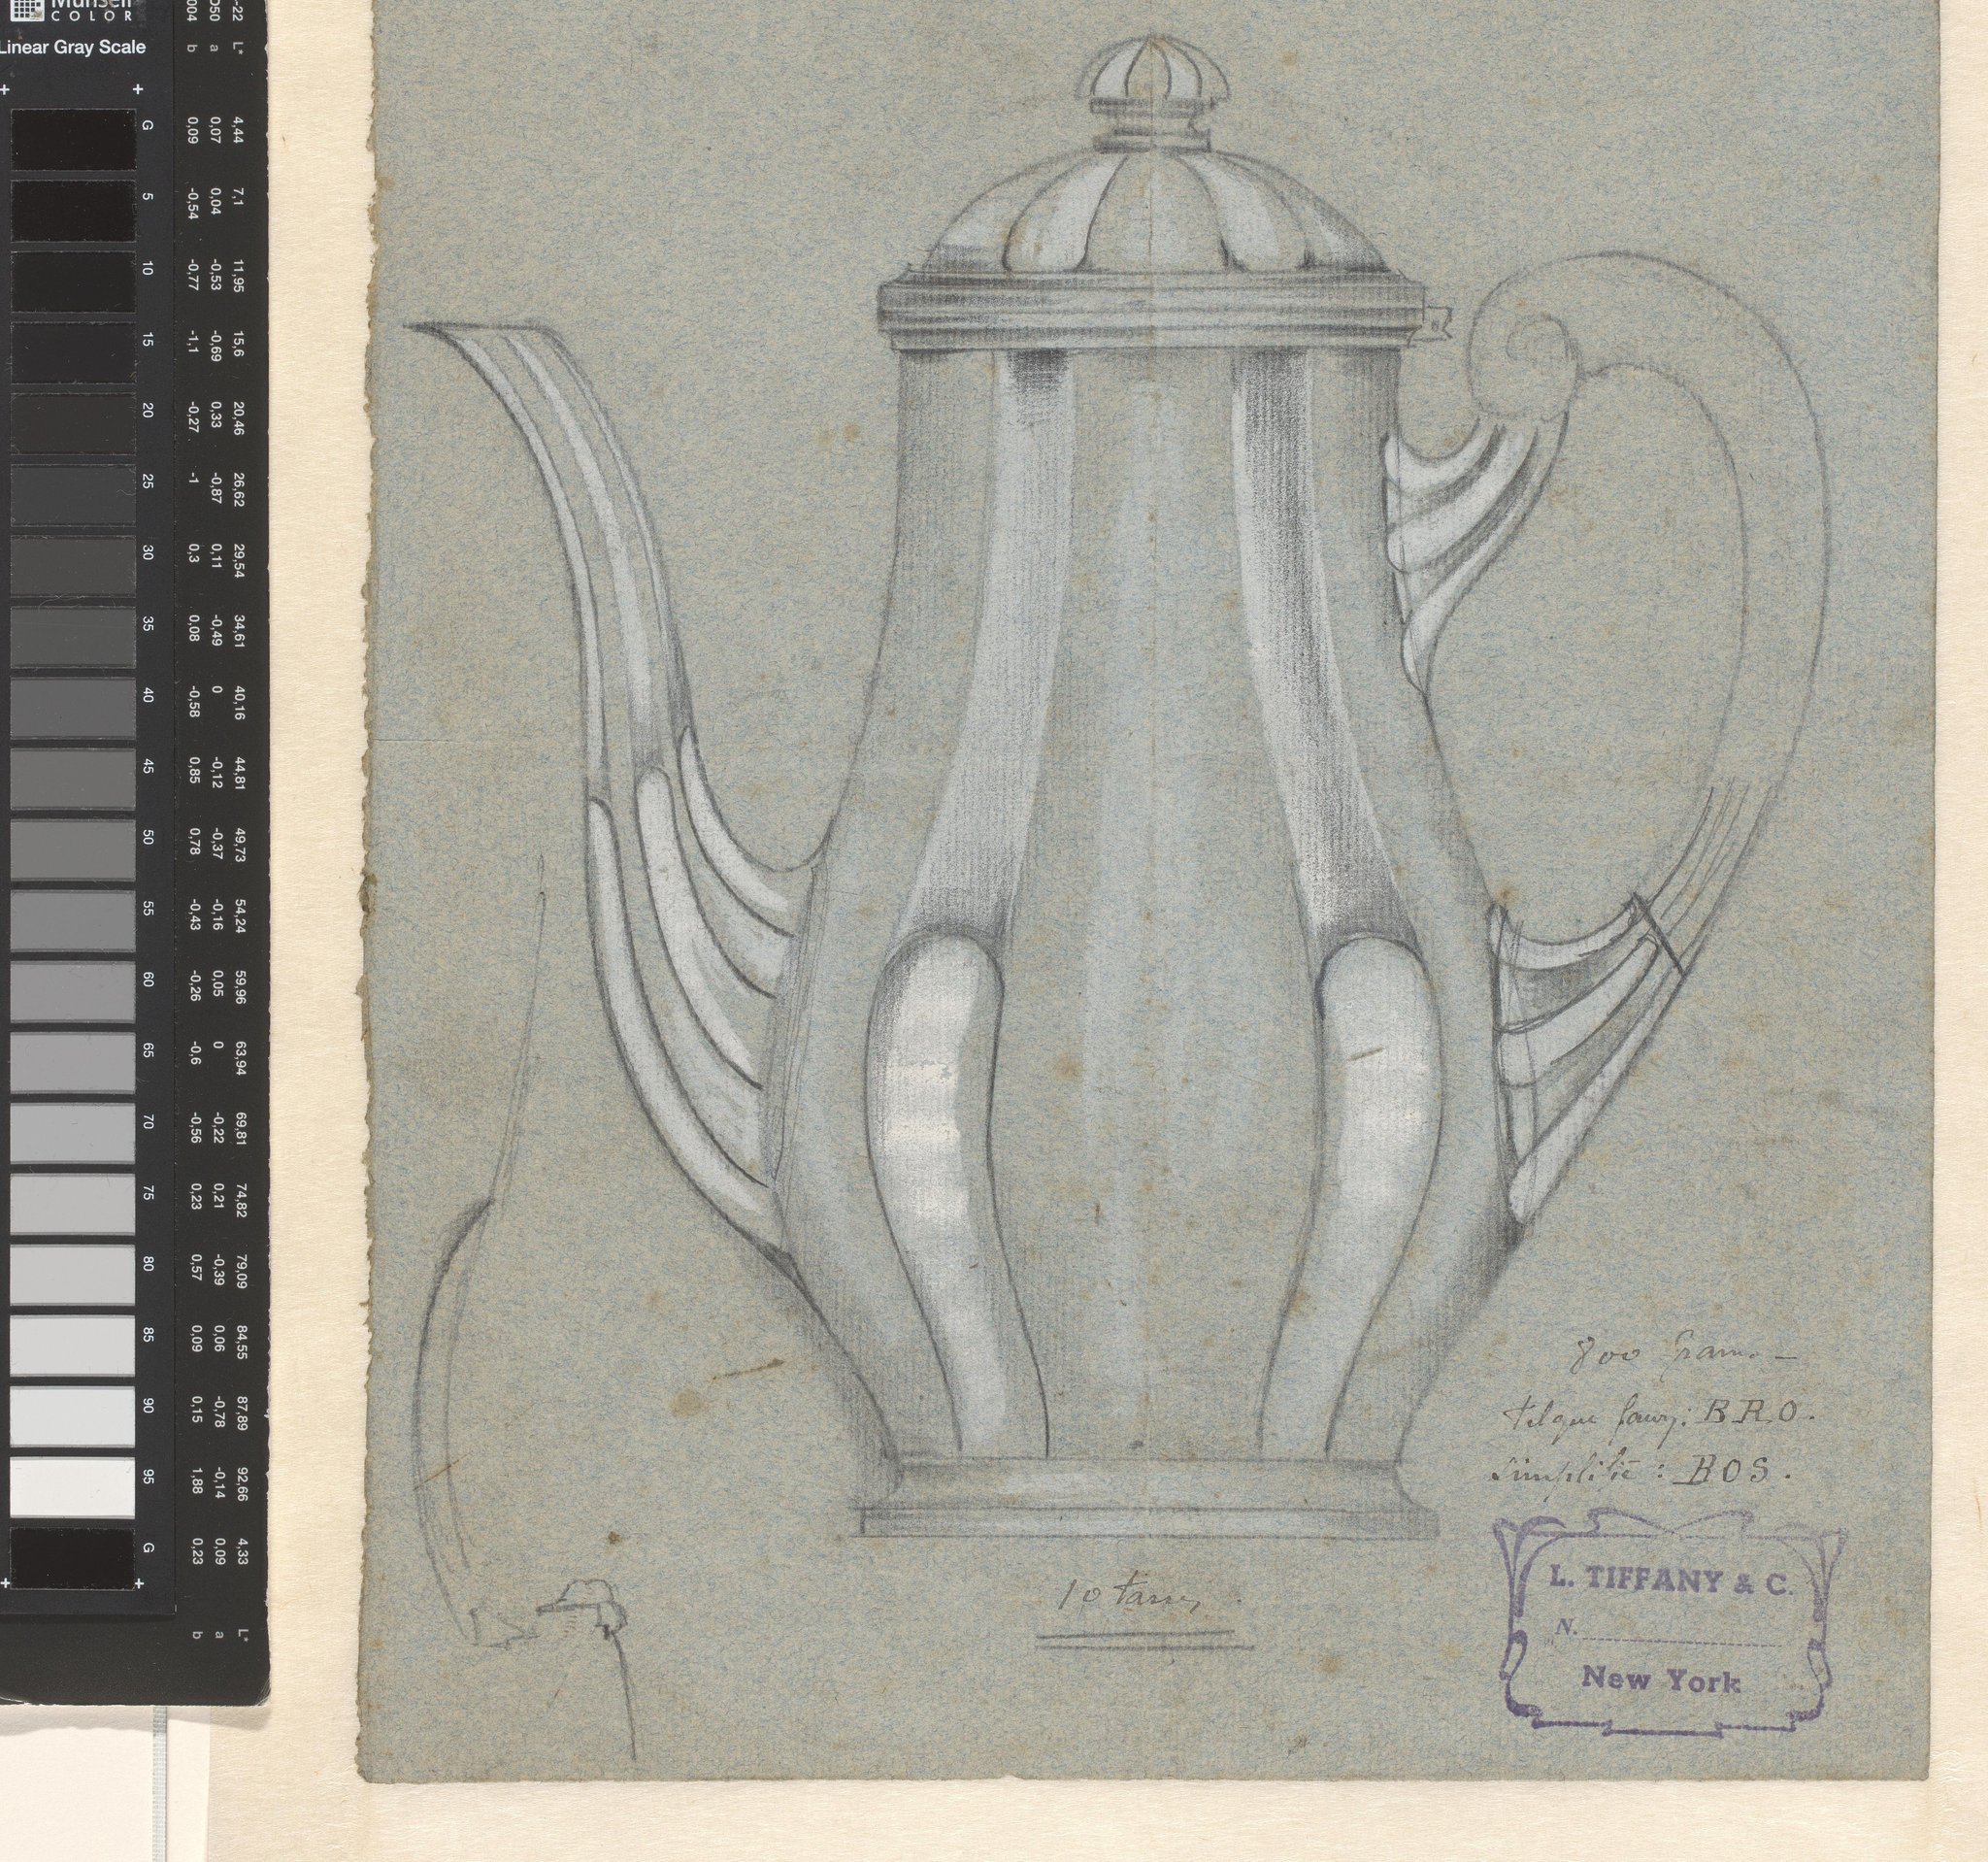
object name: design drawing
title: Ontwerp voor een koffiepot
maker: louis comfort tiffany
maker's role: designer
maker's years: 1848-1933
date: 1890-1900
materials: chalk, paper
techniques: brush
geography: new york city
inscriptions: stamp: ‘L. TIFFANY & C. / N. / New York’, inscription: ‘VII / 800 Grams / Tel que faur[?] : BRO. / Simplifié: BOS. / 10 tasses’, watermark: ‘M B M, (FT’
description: Ontwerp voor een koffiepot versierd met godrons met linksonder schets voor detail.